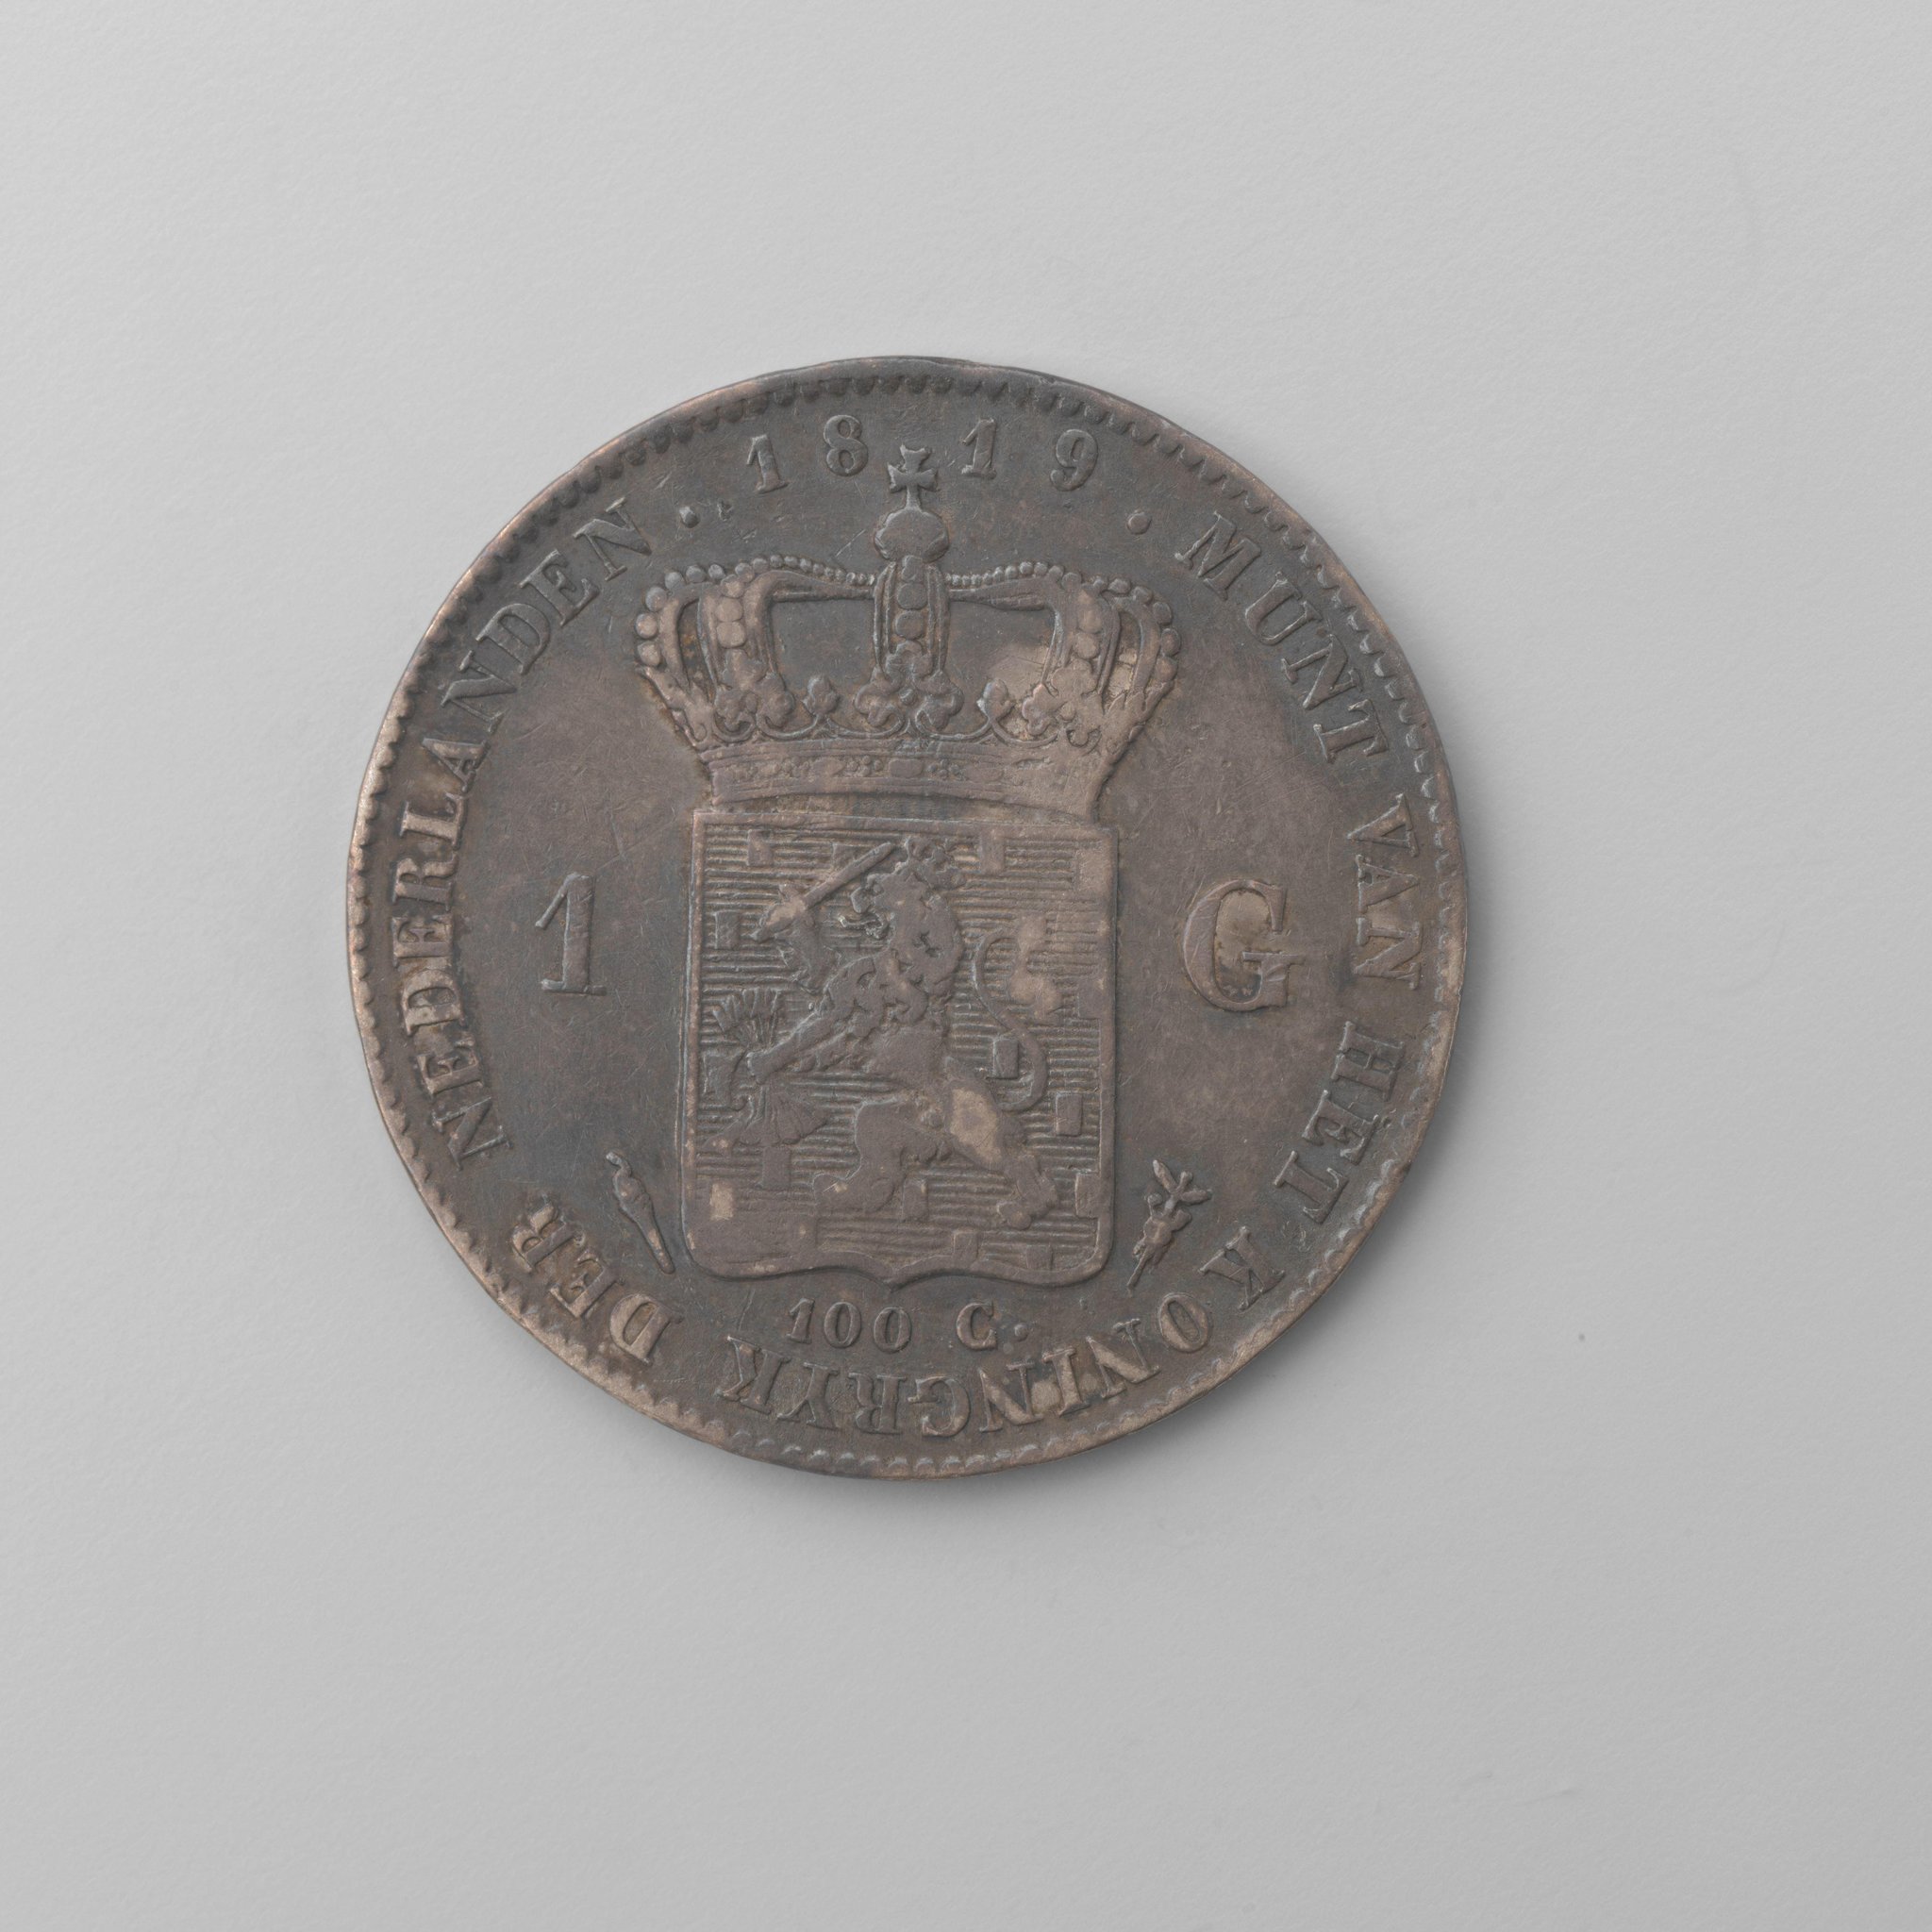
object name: coin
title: Nederland, gulden, 1819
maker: william i of the netherlands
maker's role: koning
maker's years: 1772-1843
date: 1819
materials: silver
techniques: striking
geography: utrecht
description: Zilveren munt. Voorzijde: borstbeeld naar rechts. Keerzijde: tussen waarde-aanduiding 1 G gekroond rijkswapenschild. Jaartal boven kroon. Randschrift.